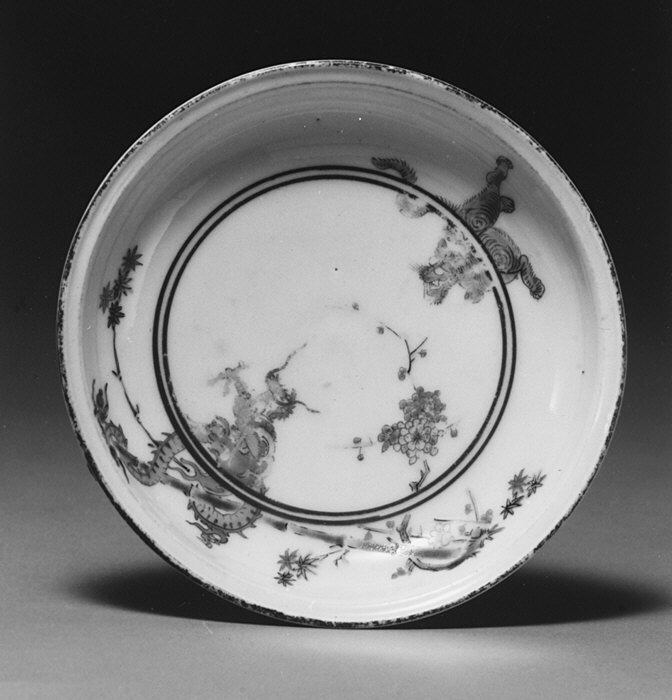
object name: saucer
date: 1700-1720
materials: hard paste porcelain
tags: dragons,flowers